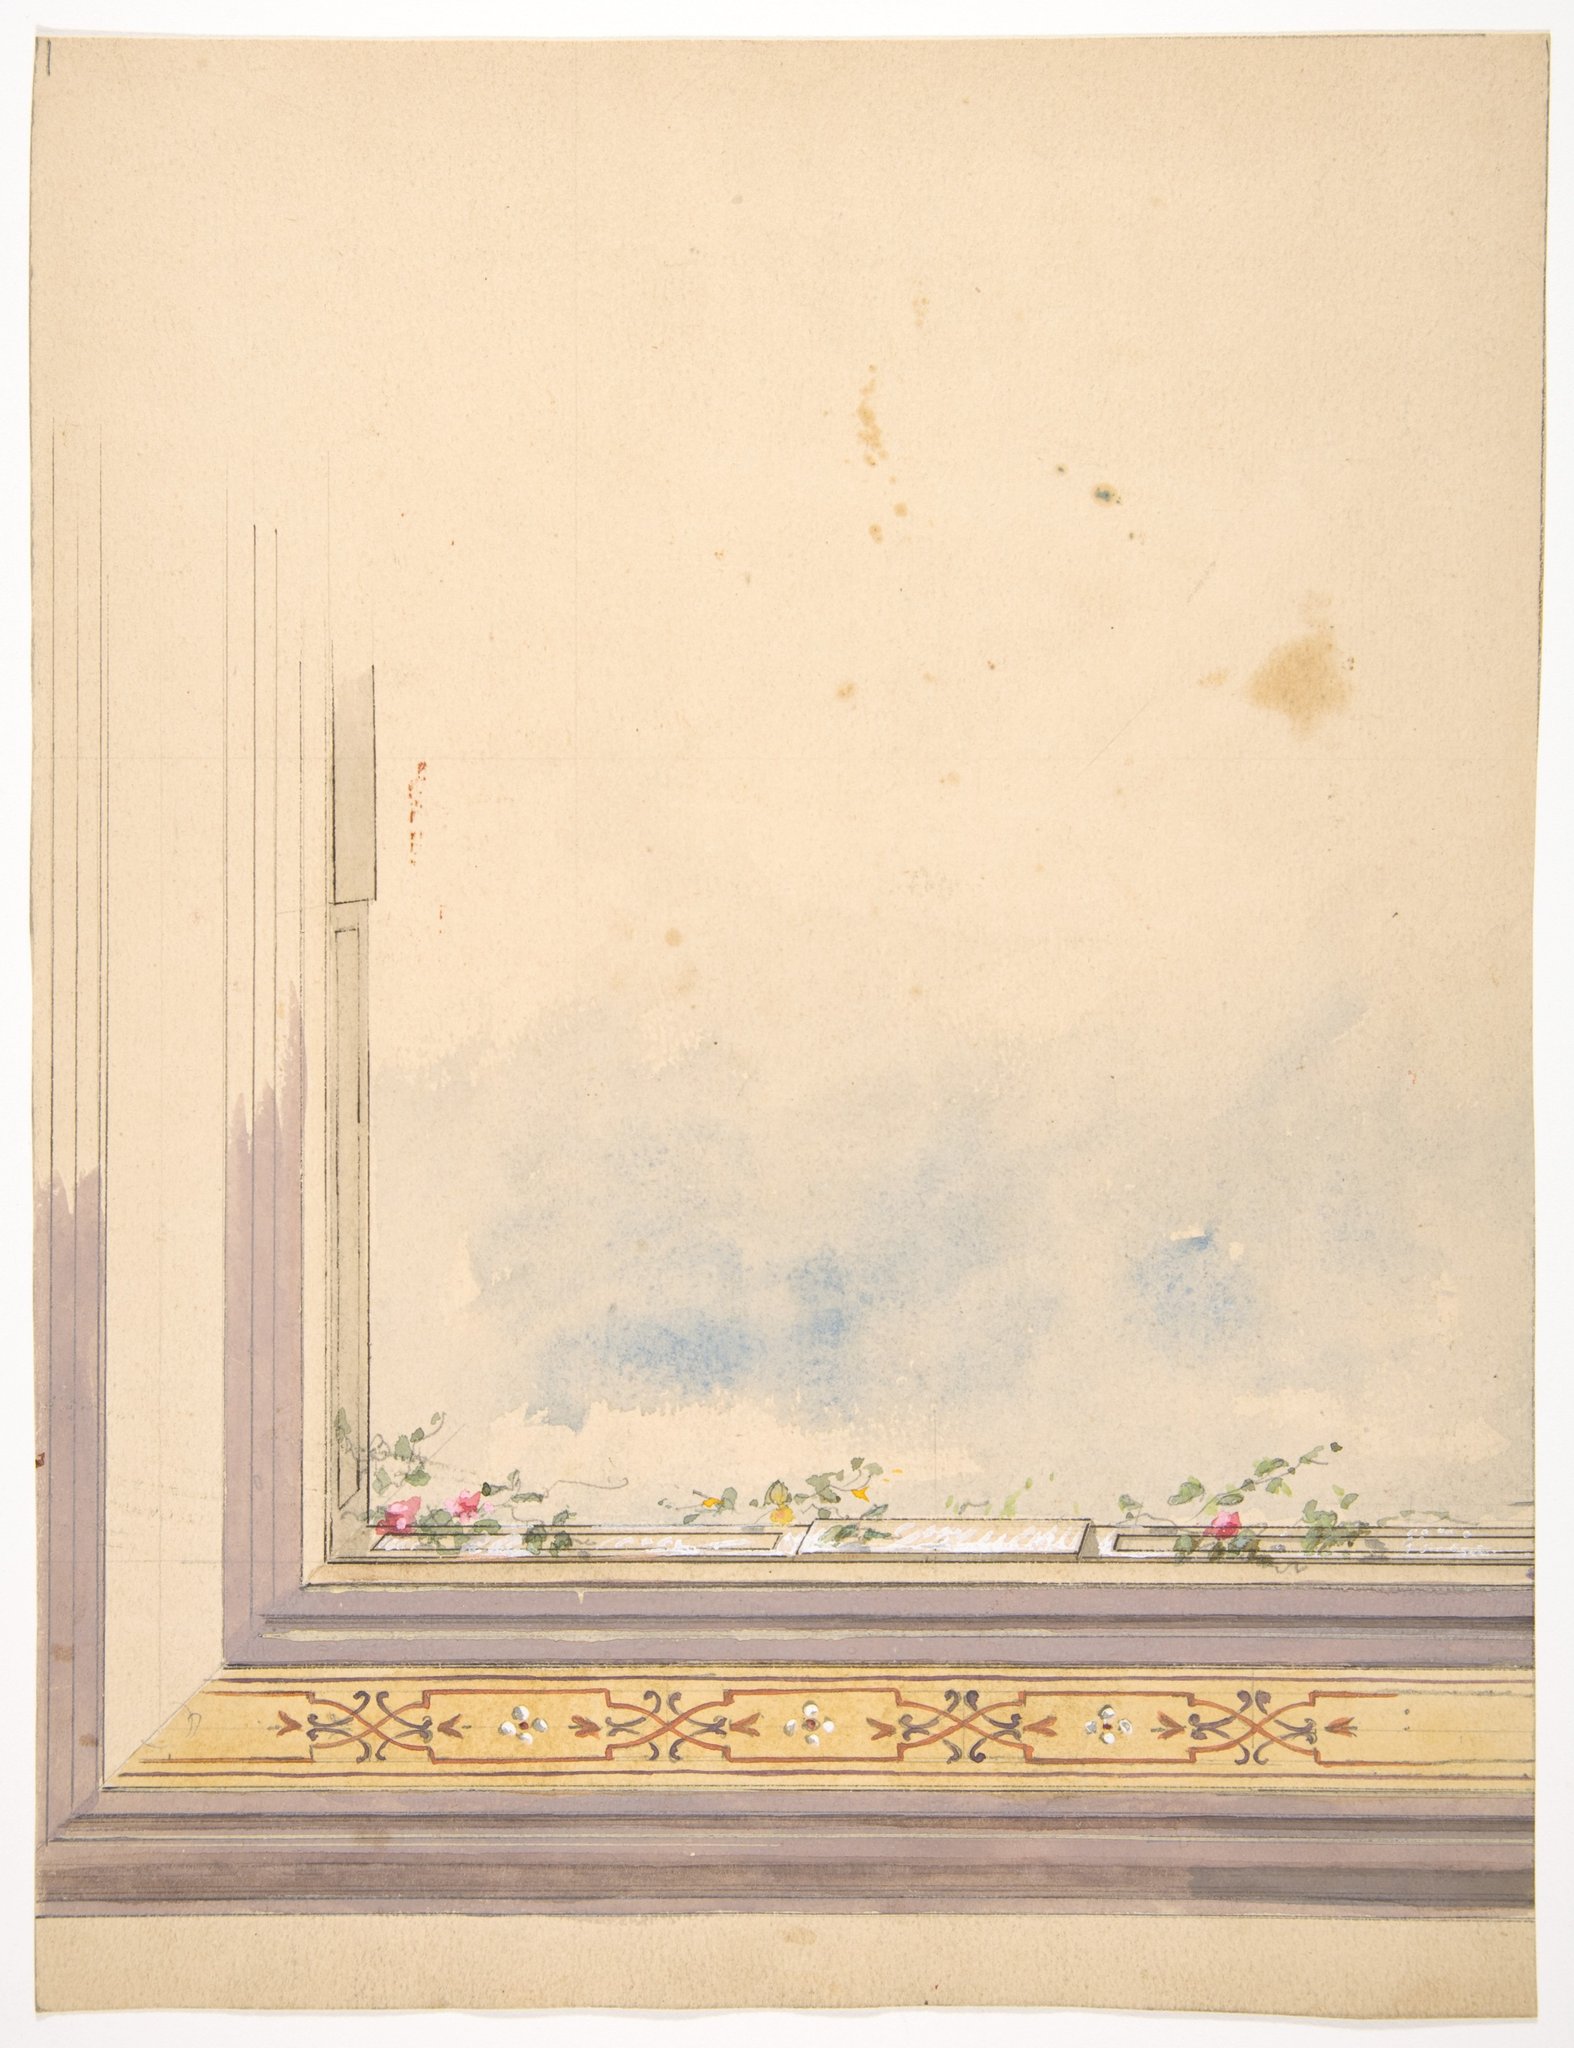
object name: drawing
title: Design for a ceiling painted with clouds and flowering vines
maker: jules-edmond-charles lachaise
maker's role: artist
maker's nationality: french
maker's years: 1897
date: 1830-1897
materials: graphite, ink, watercolor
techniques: pen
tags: architecture